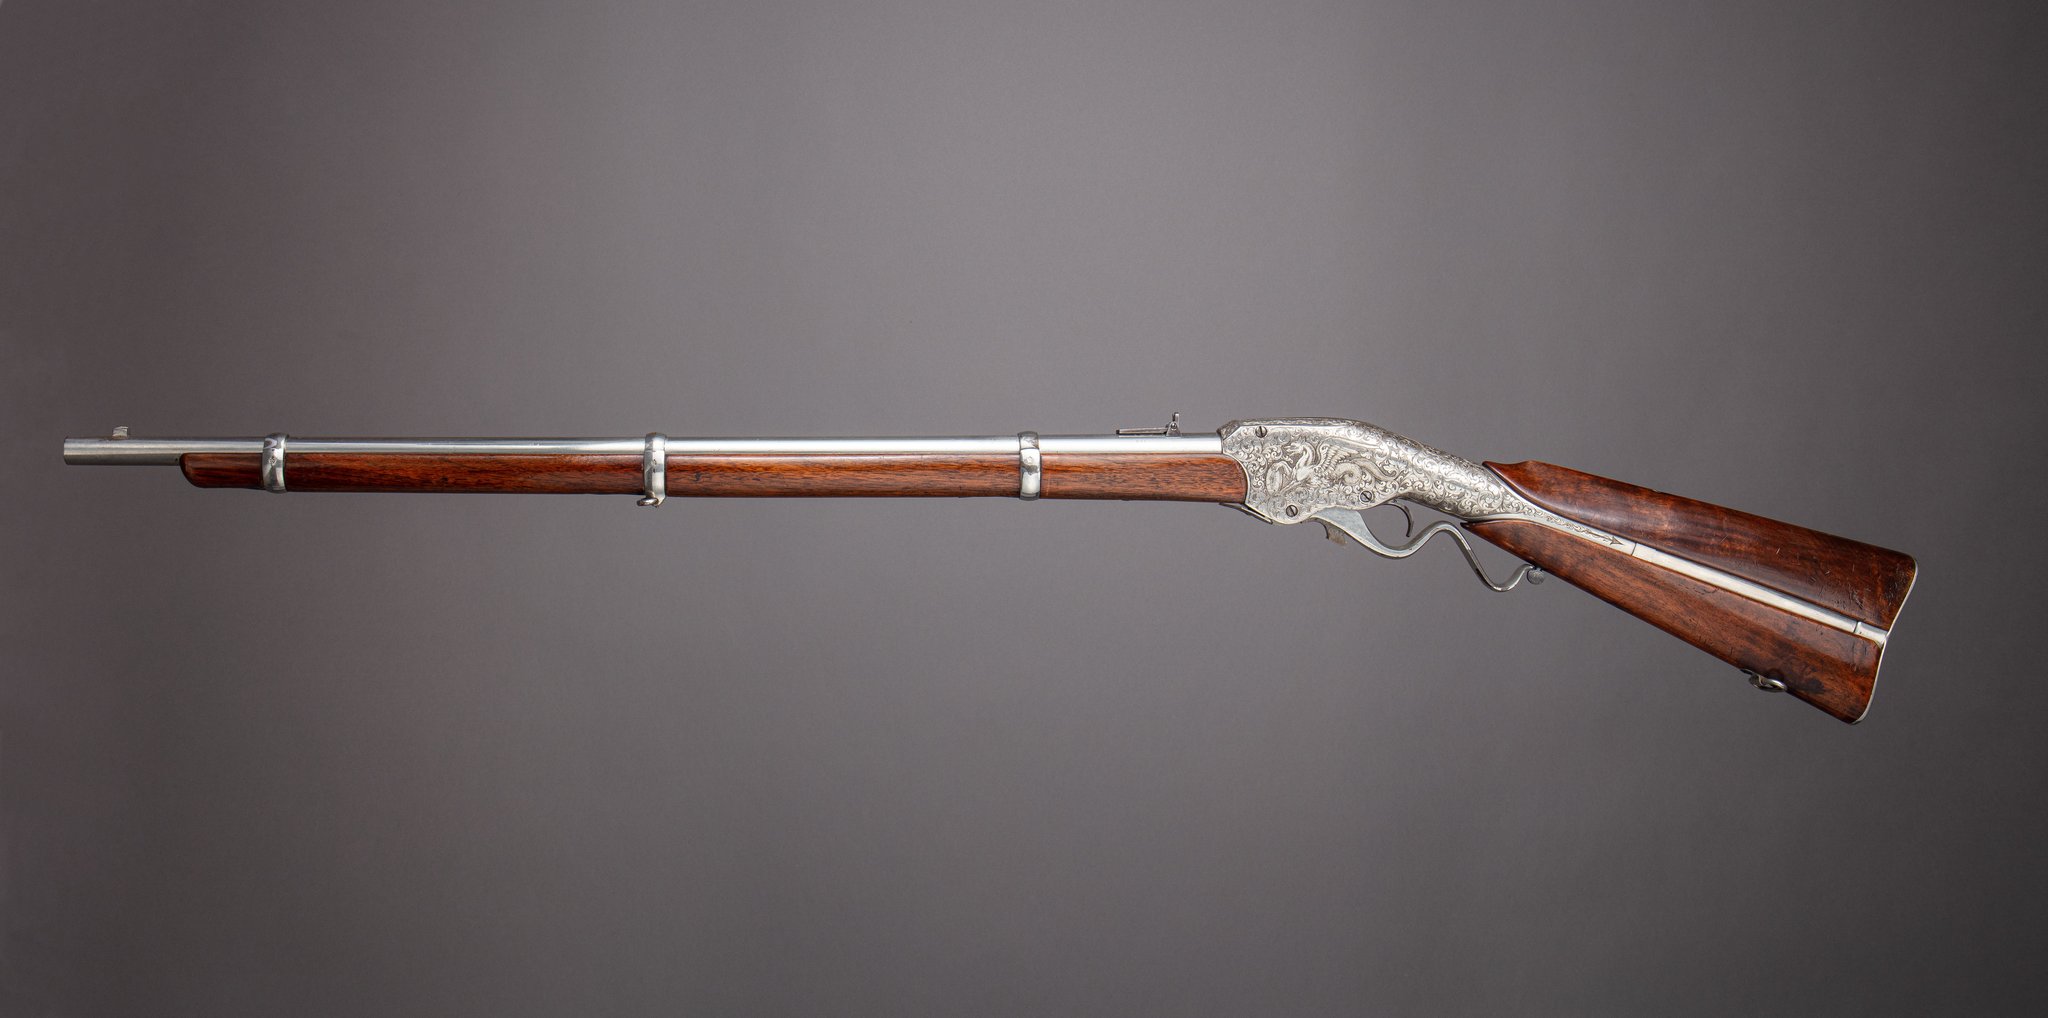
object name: musket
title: Evans Repeating Rifle Co. Transition Model Lever Action Musket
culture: american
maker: evans repeating rifle company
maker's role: manufacturer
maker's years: 1873-1881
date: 1876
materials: nickel, steel, wood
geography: united states